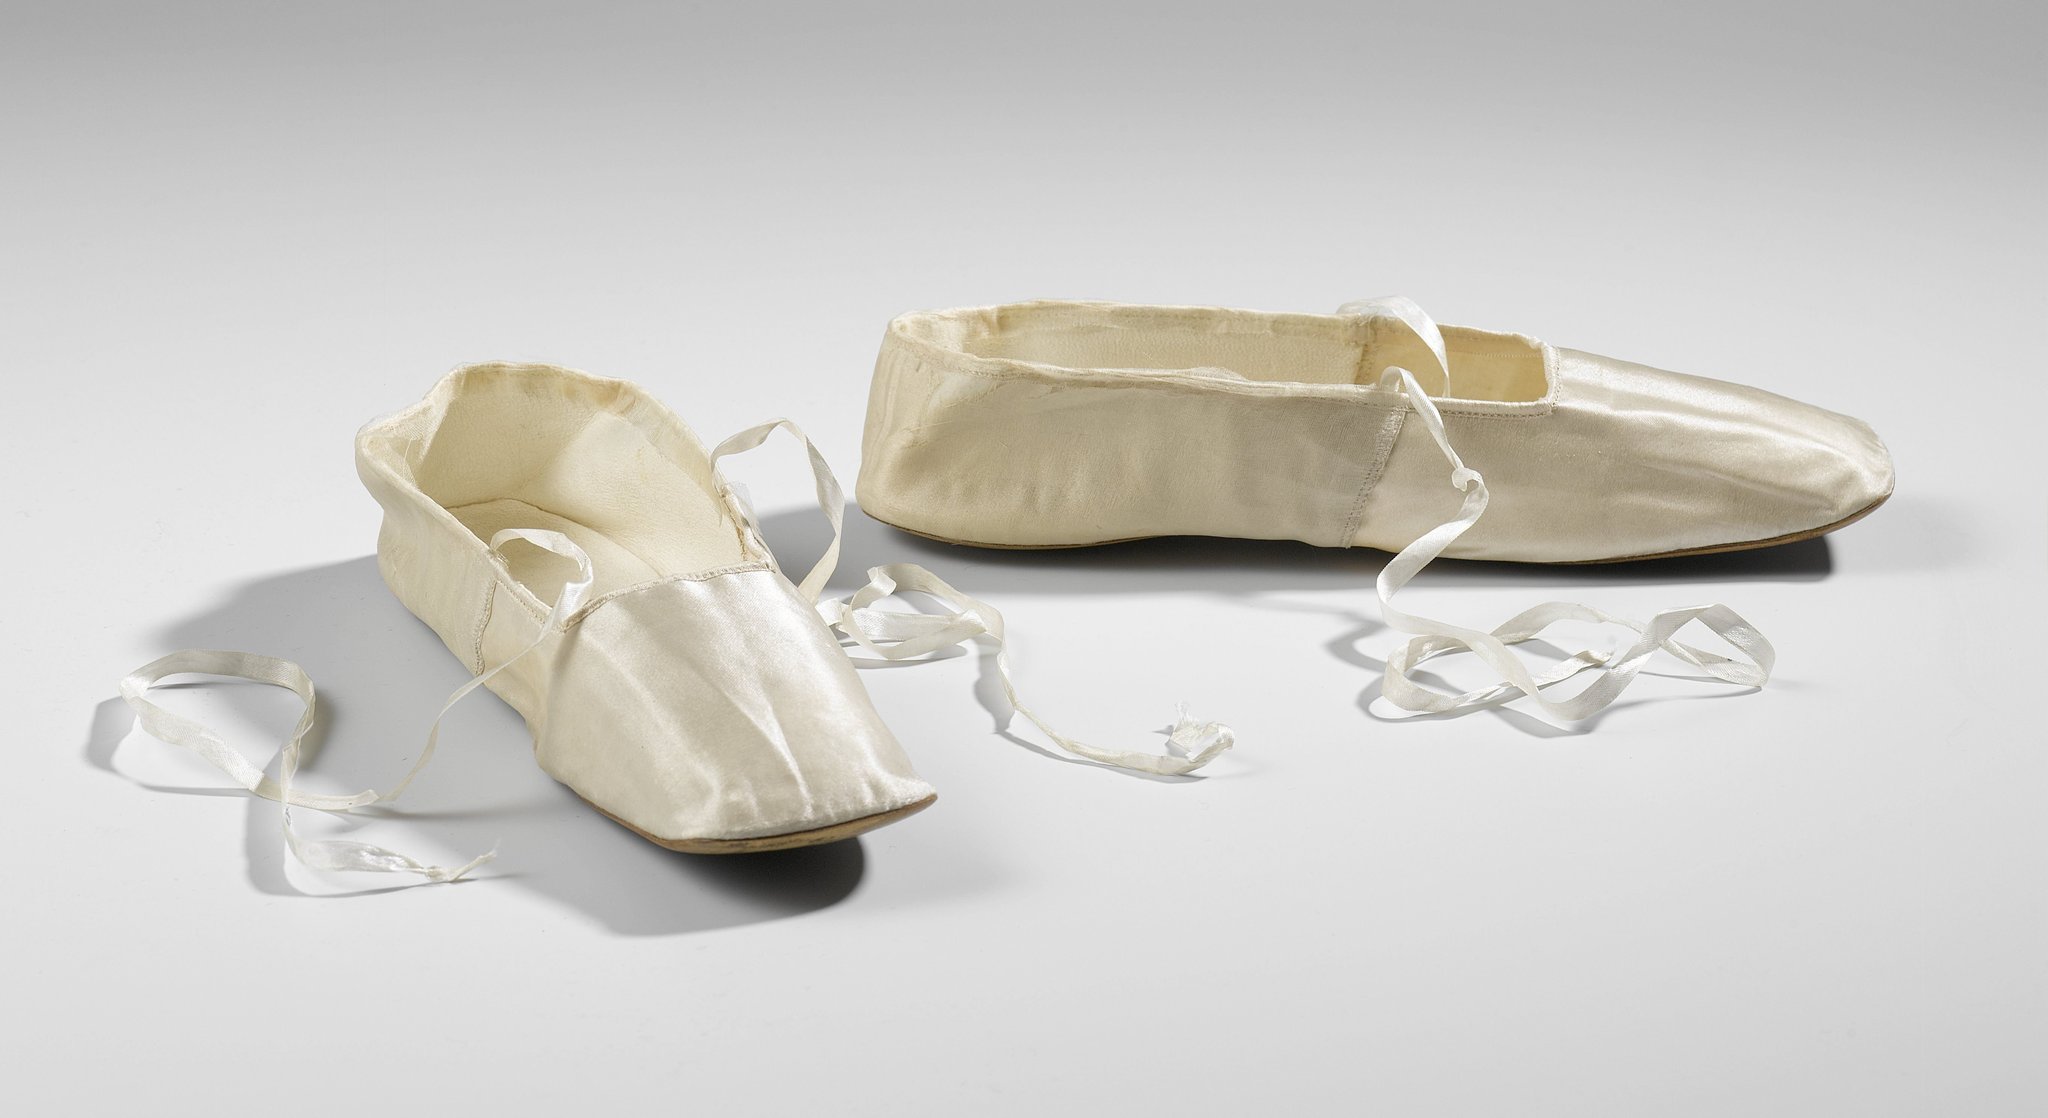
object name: shoe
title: Pair of shoes with ribbon laces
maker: hendrik willem berenbak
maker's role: schoenmaker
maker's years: 1802-1874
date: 1813-1825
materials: leather, paper, ink, silk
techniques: printing, tanning, weave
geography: the hague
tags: the hague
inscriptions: name: ‘H.W. BERENBAK, CORDONNIER POUR DAMES, PLACE 15.’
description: At first sight, these appear to be standard shoes from the first quarter of the 19th century. What is unusual, however, is the printed label on the insole. It bears the name of the cobbler and his address (15 Plaats in The Hague). Until then, craftsmen had generally remained anonymous. Also indicated in each shoe is for which foot it was intended.